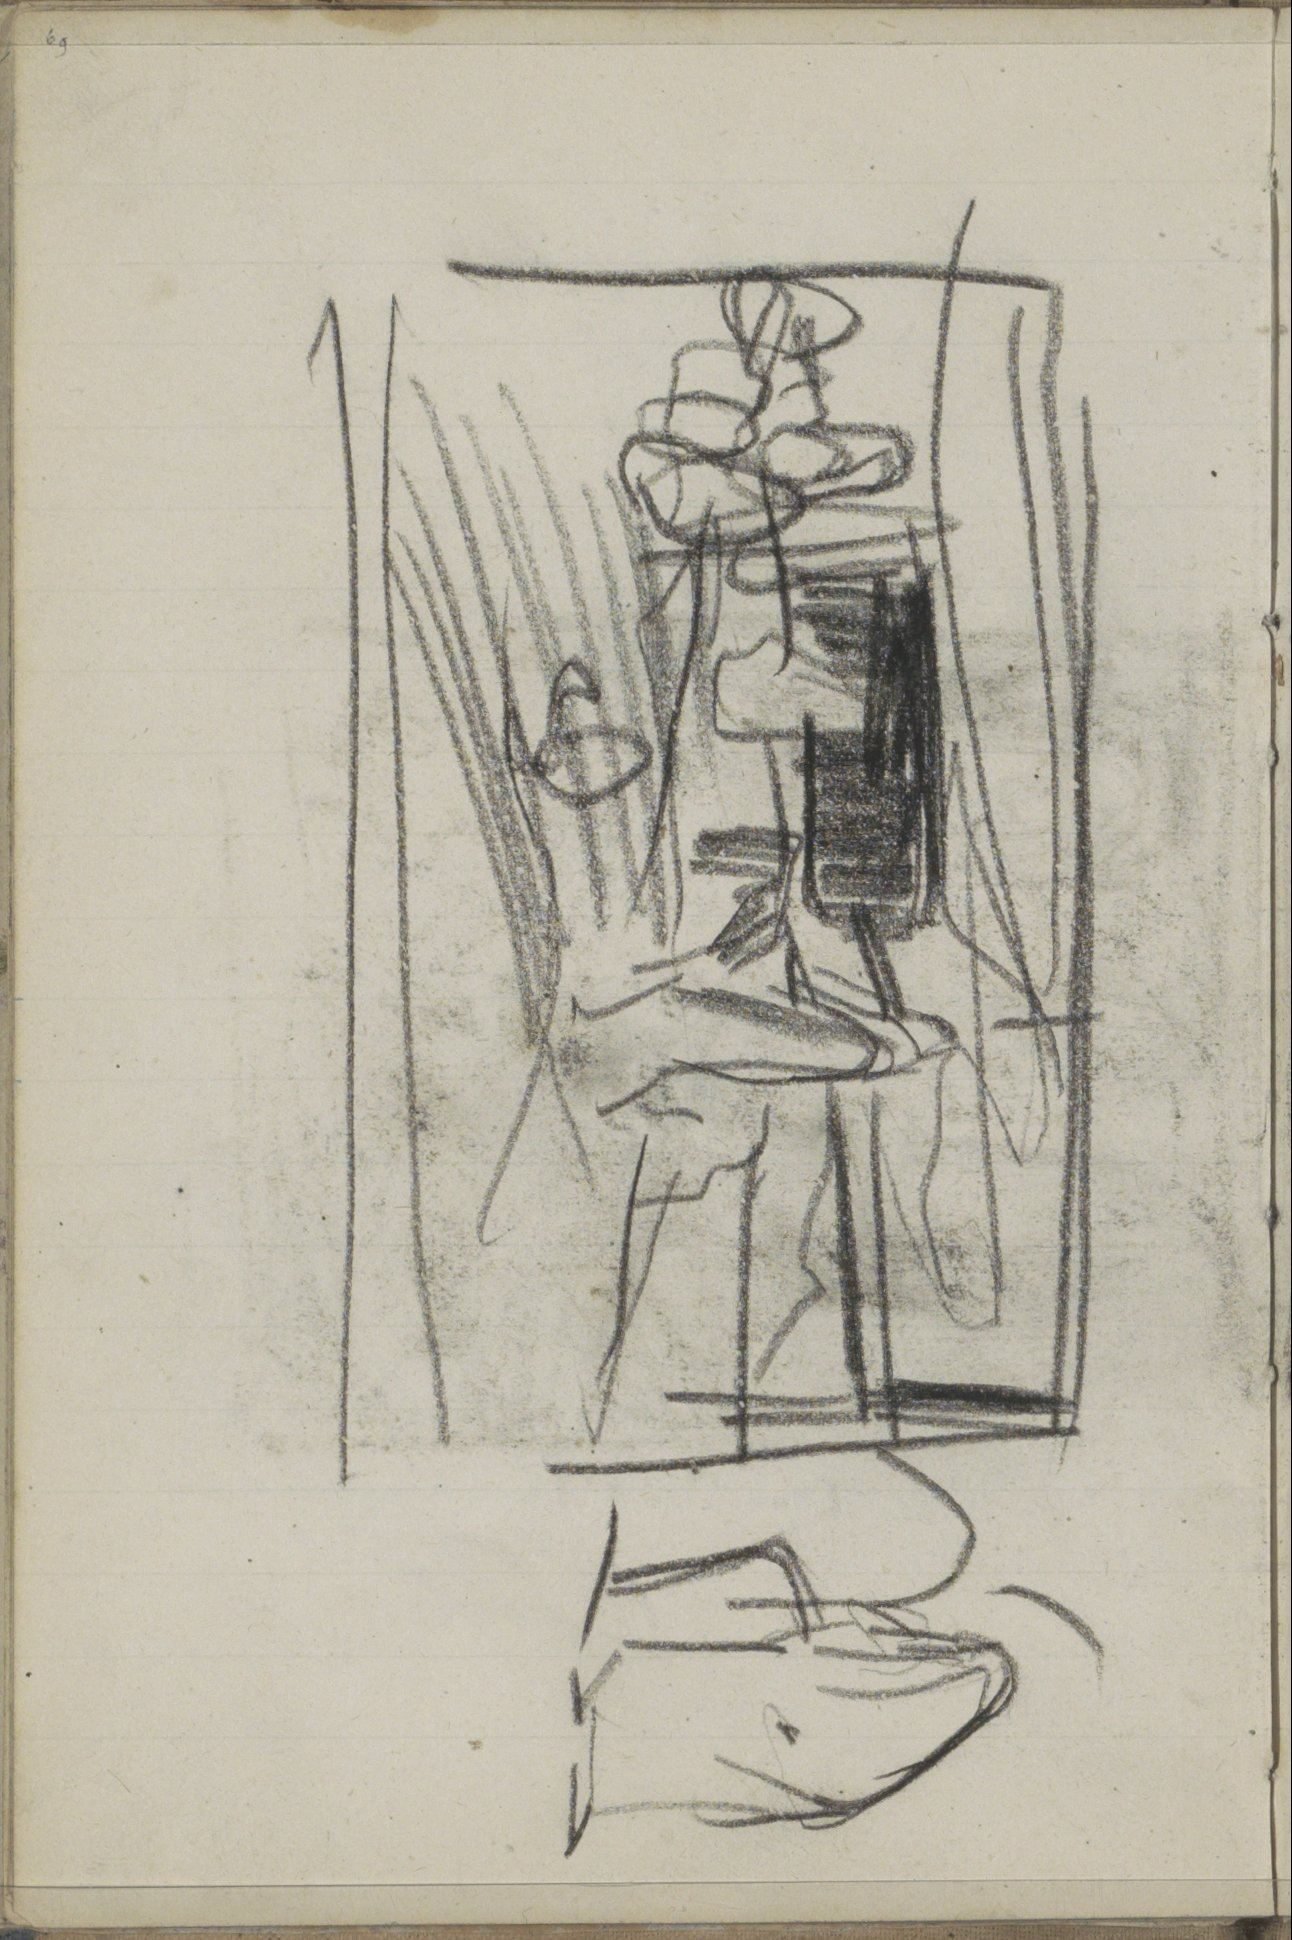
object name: sketchbook leaf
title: Figuur in een straat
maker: marius bauer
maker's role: draughtsman, print maker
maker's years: 1867-1932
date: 1888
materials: chalk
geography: istanbul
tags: asiatic races and peoples, street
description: Tevens een figuurstudie. Pagina 69 uit een schetsboek met 58 bladen.